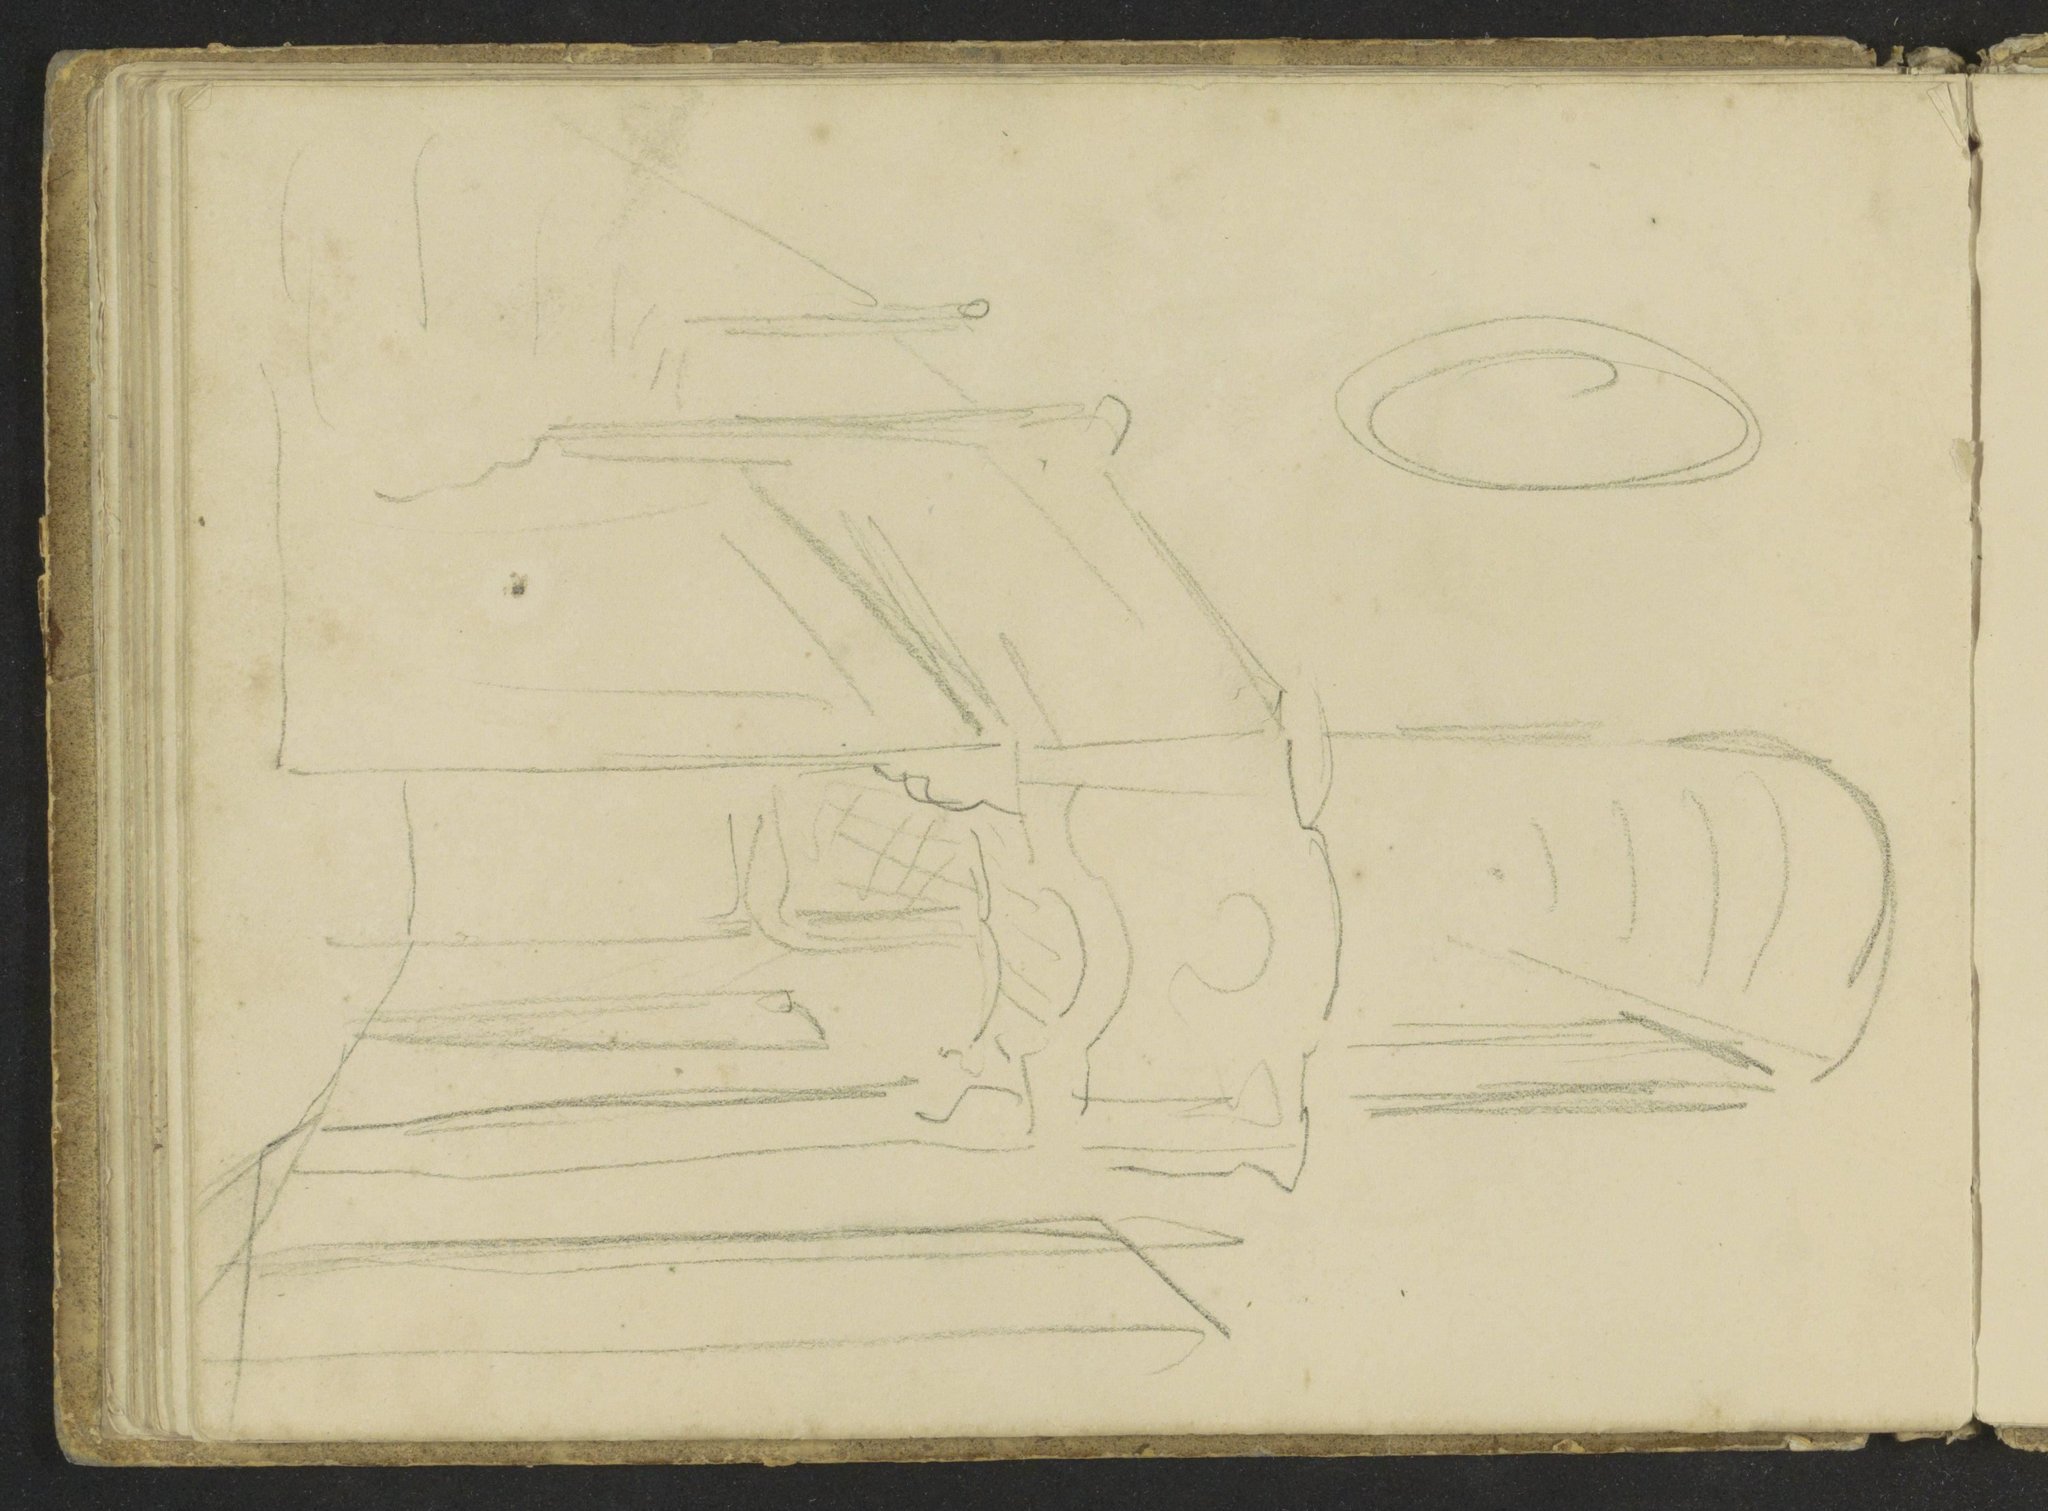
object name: sketchbook leaf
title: Gebogen trap richting een gang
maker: willem hendrik schmidt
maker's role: draughtsman, painter, print maker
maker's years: 1809-1849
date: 1819-1849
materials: paper, pencil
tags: staircase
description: Blad 25 verso uit een schetsboek met 36 bladen.